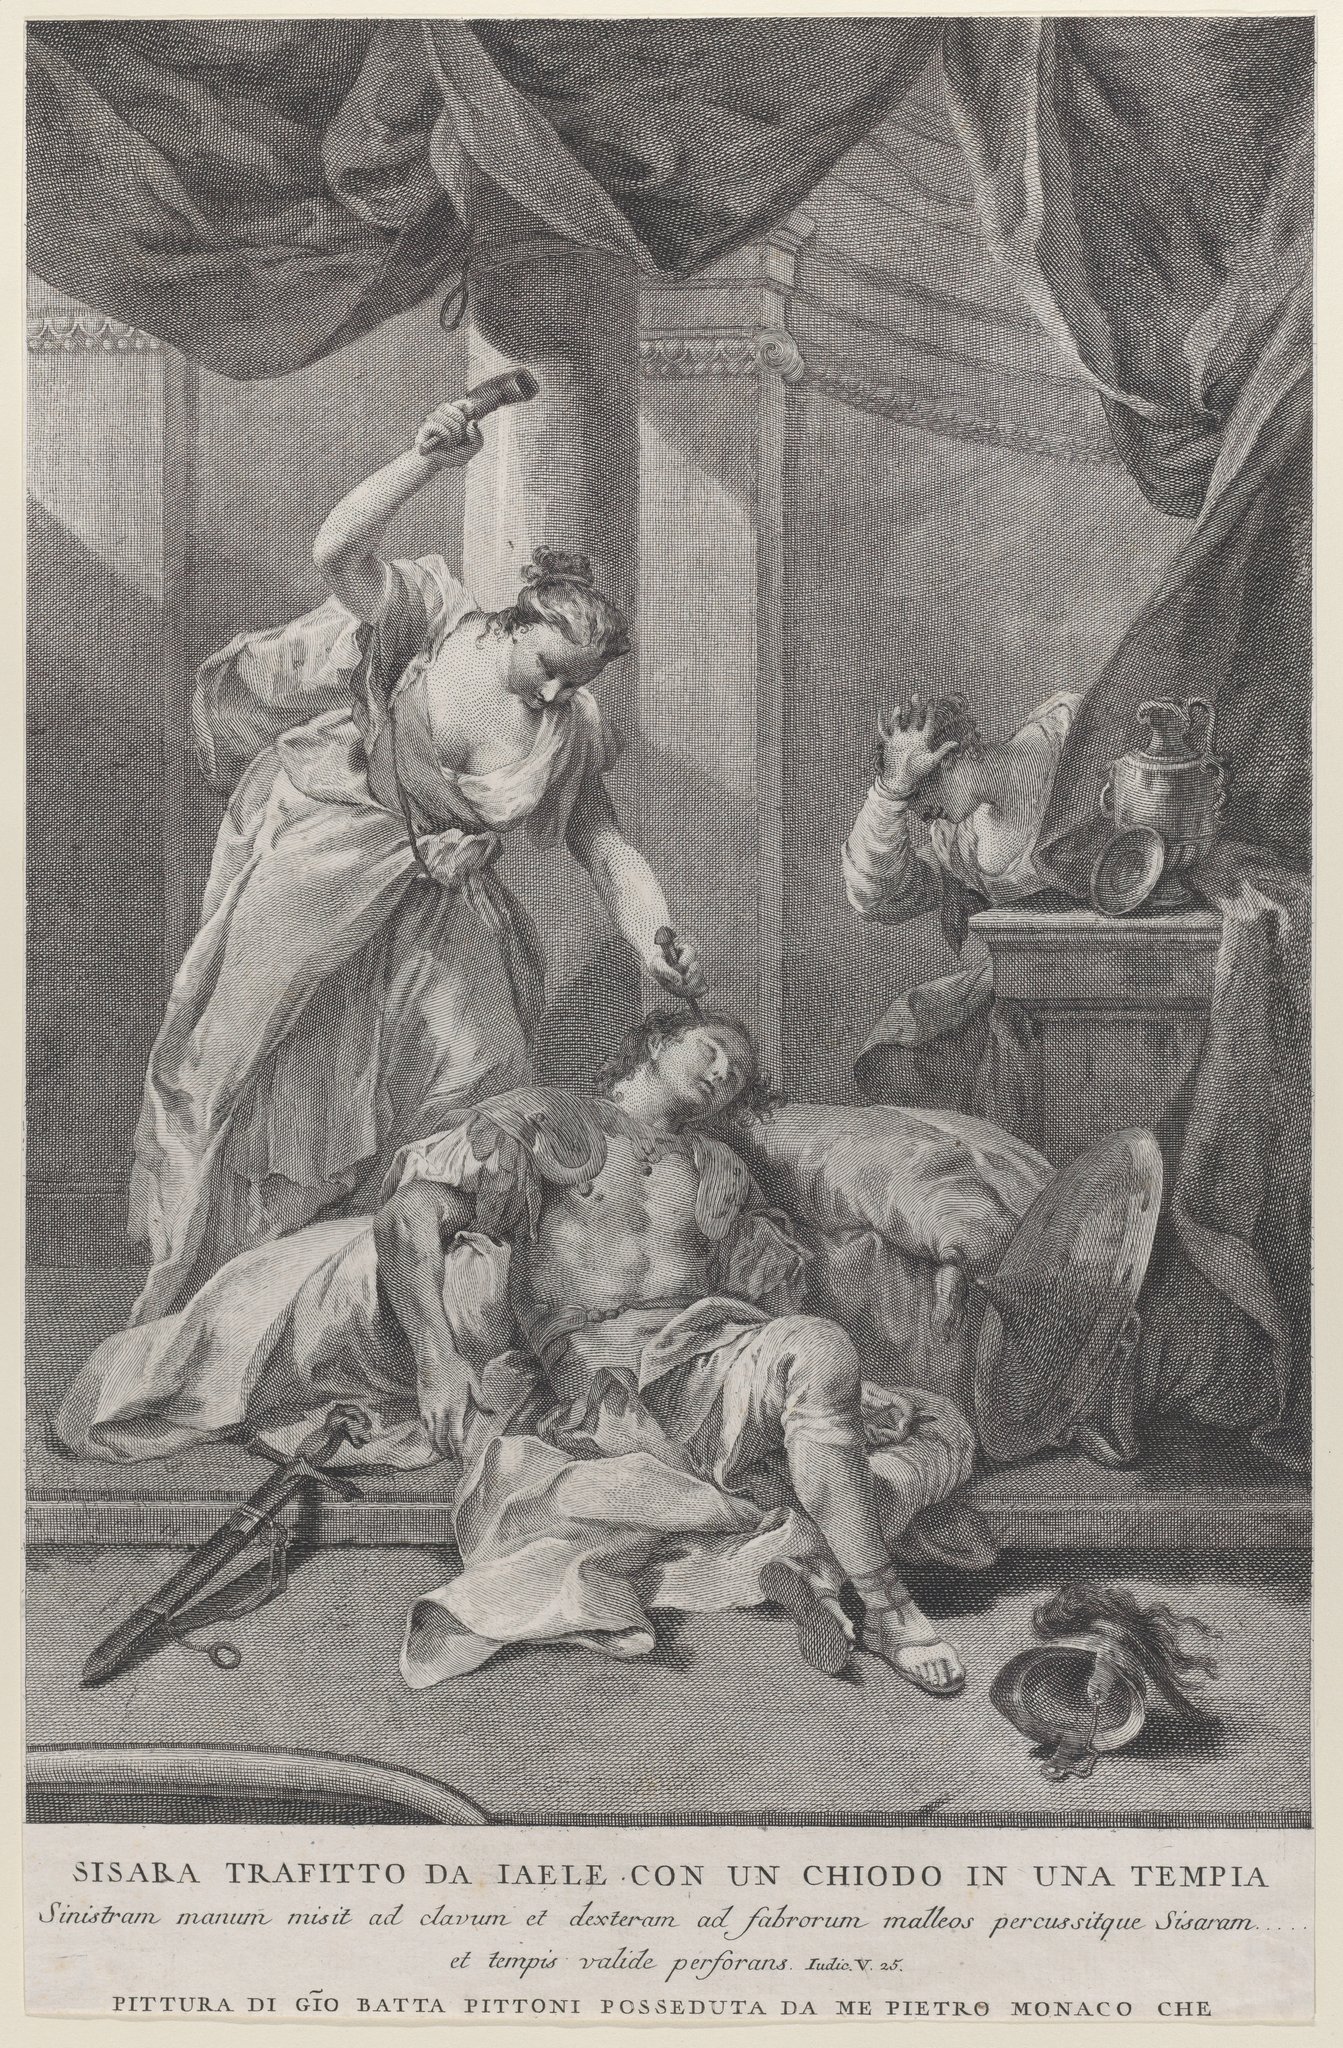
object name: print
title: Jael hammering a tent peg into the temple of the sleeping Sisera, to the right a servant hides behind a curtain; from the series of 112 prints of the sacred history, after the painting by Giovanni Battista Pittoni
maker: pietro monaco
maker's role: artist and publisher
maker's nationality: italian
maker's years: 1707-1772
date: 1730-1739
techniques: engraving, etching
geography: venice